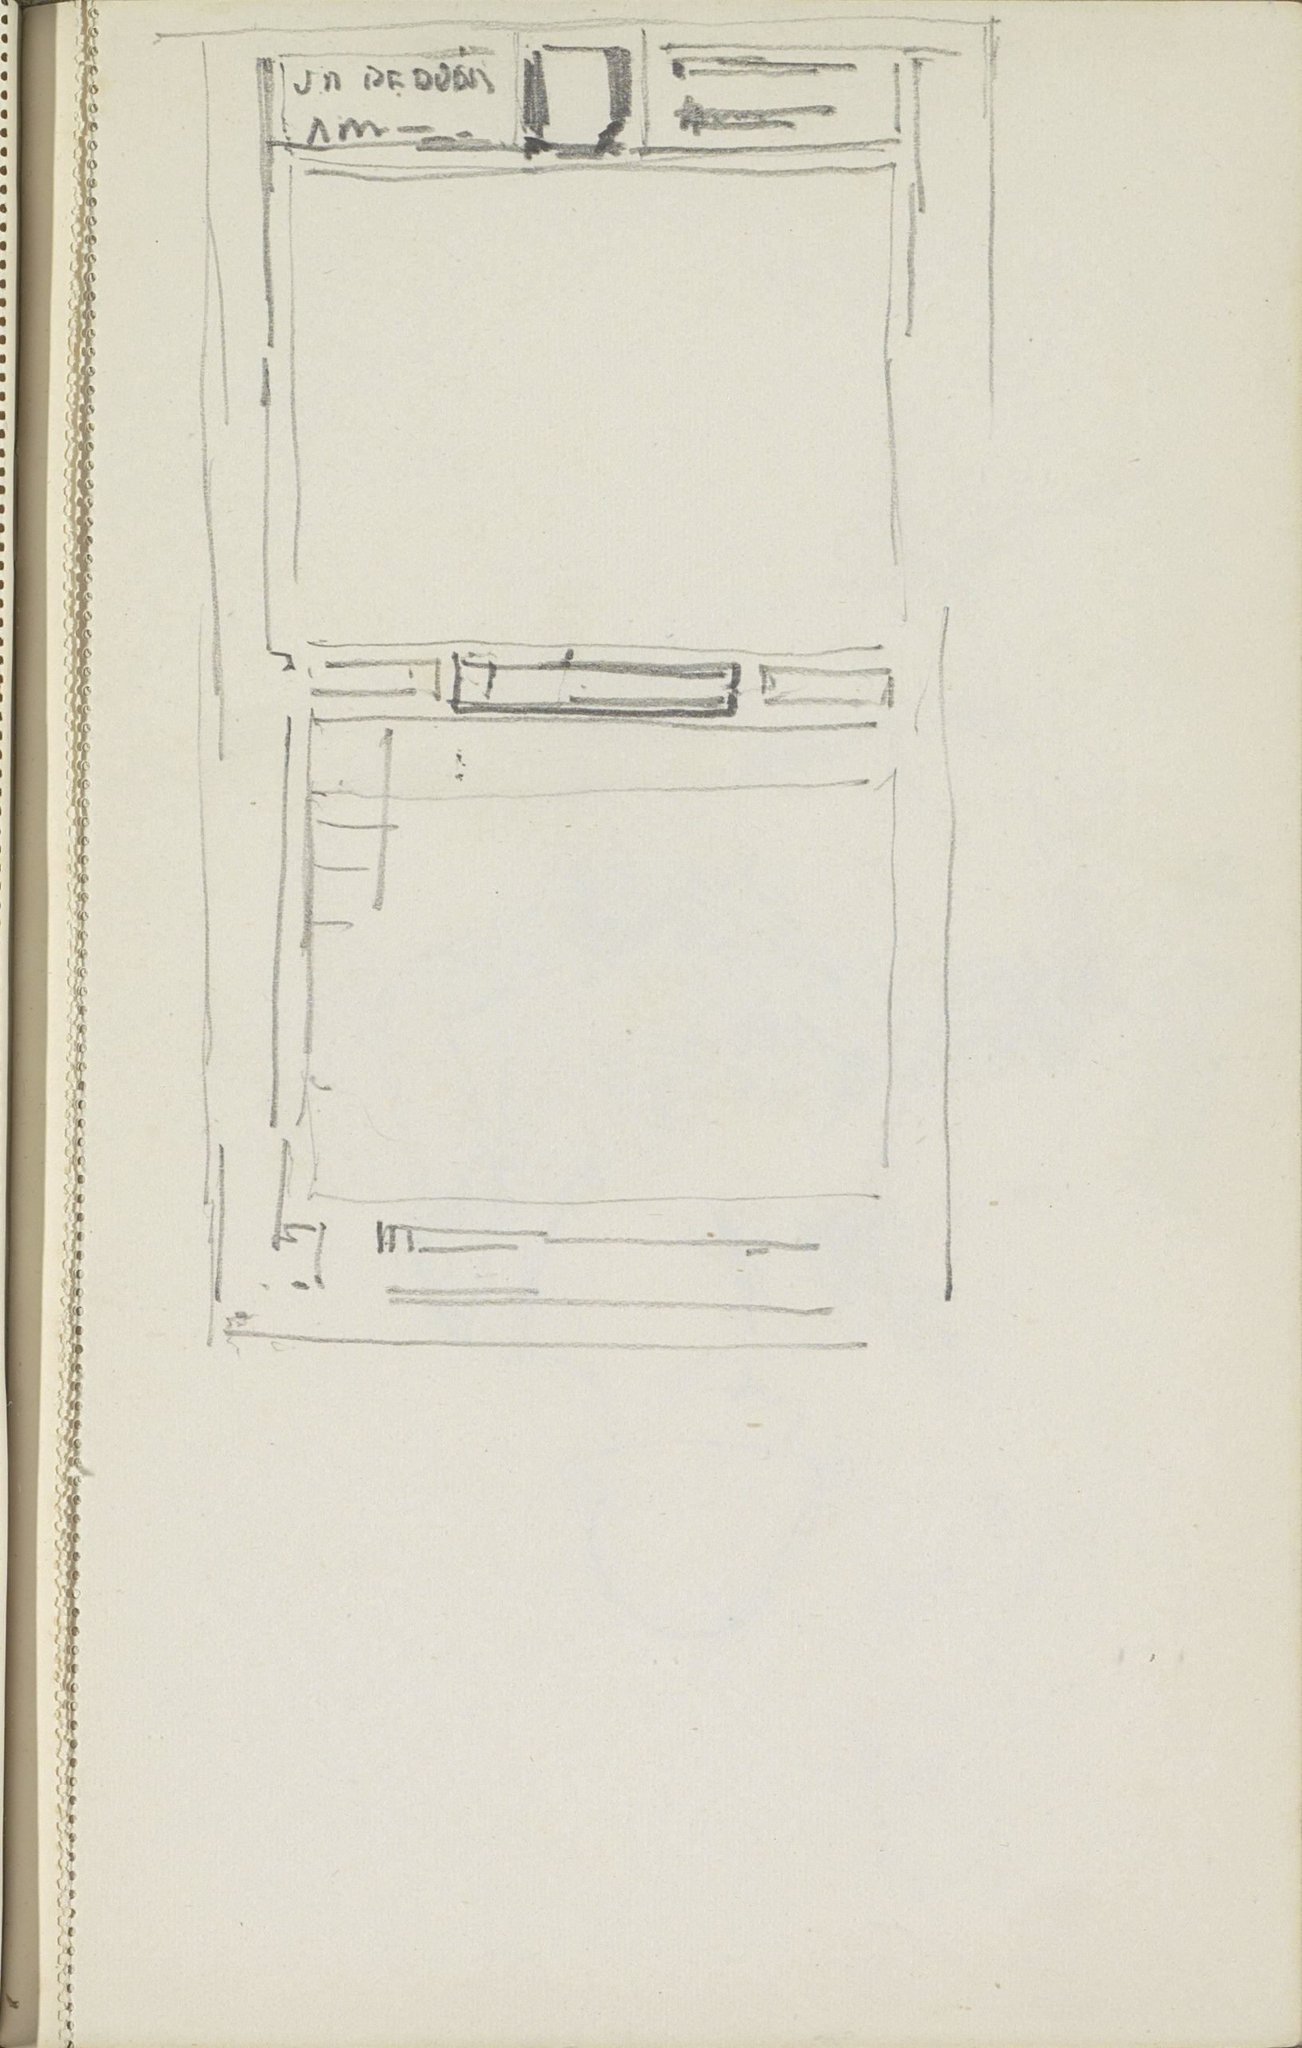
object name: sketchbook leaf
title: Studie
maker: cornelis vreedenburgh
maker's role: draughtsman, print maker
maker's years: 1880-1946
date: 1890-1946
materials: paper, pencil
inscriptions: annotation: ‘Jn De Do[...]/ AM’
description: Mogelijk een ontwerp voor een boekomslag. Blad 48 recto uit een schetsboek met 50 bladen.